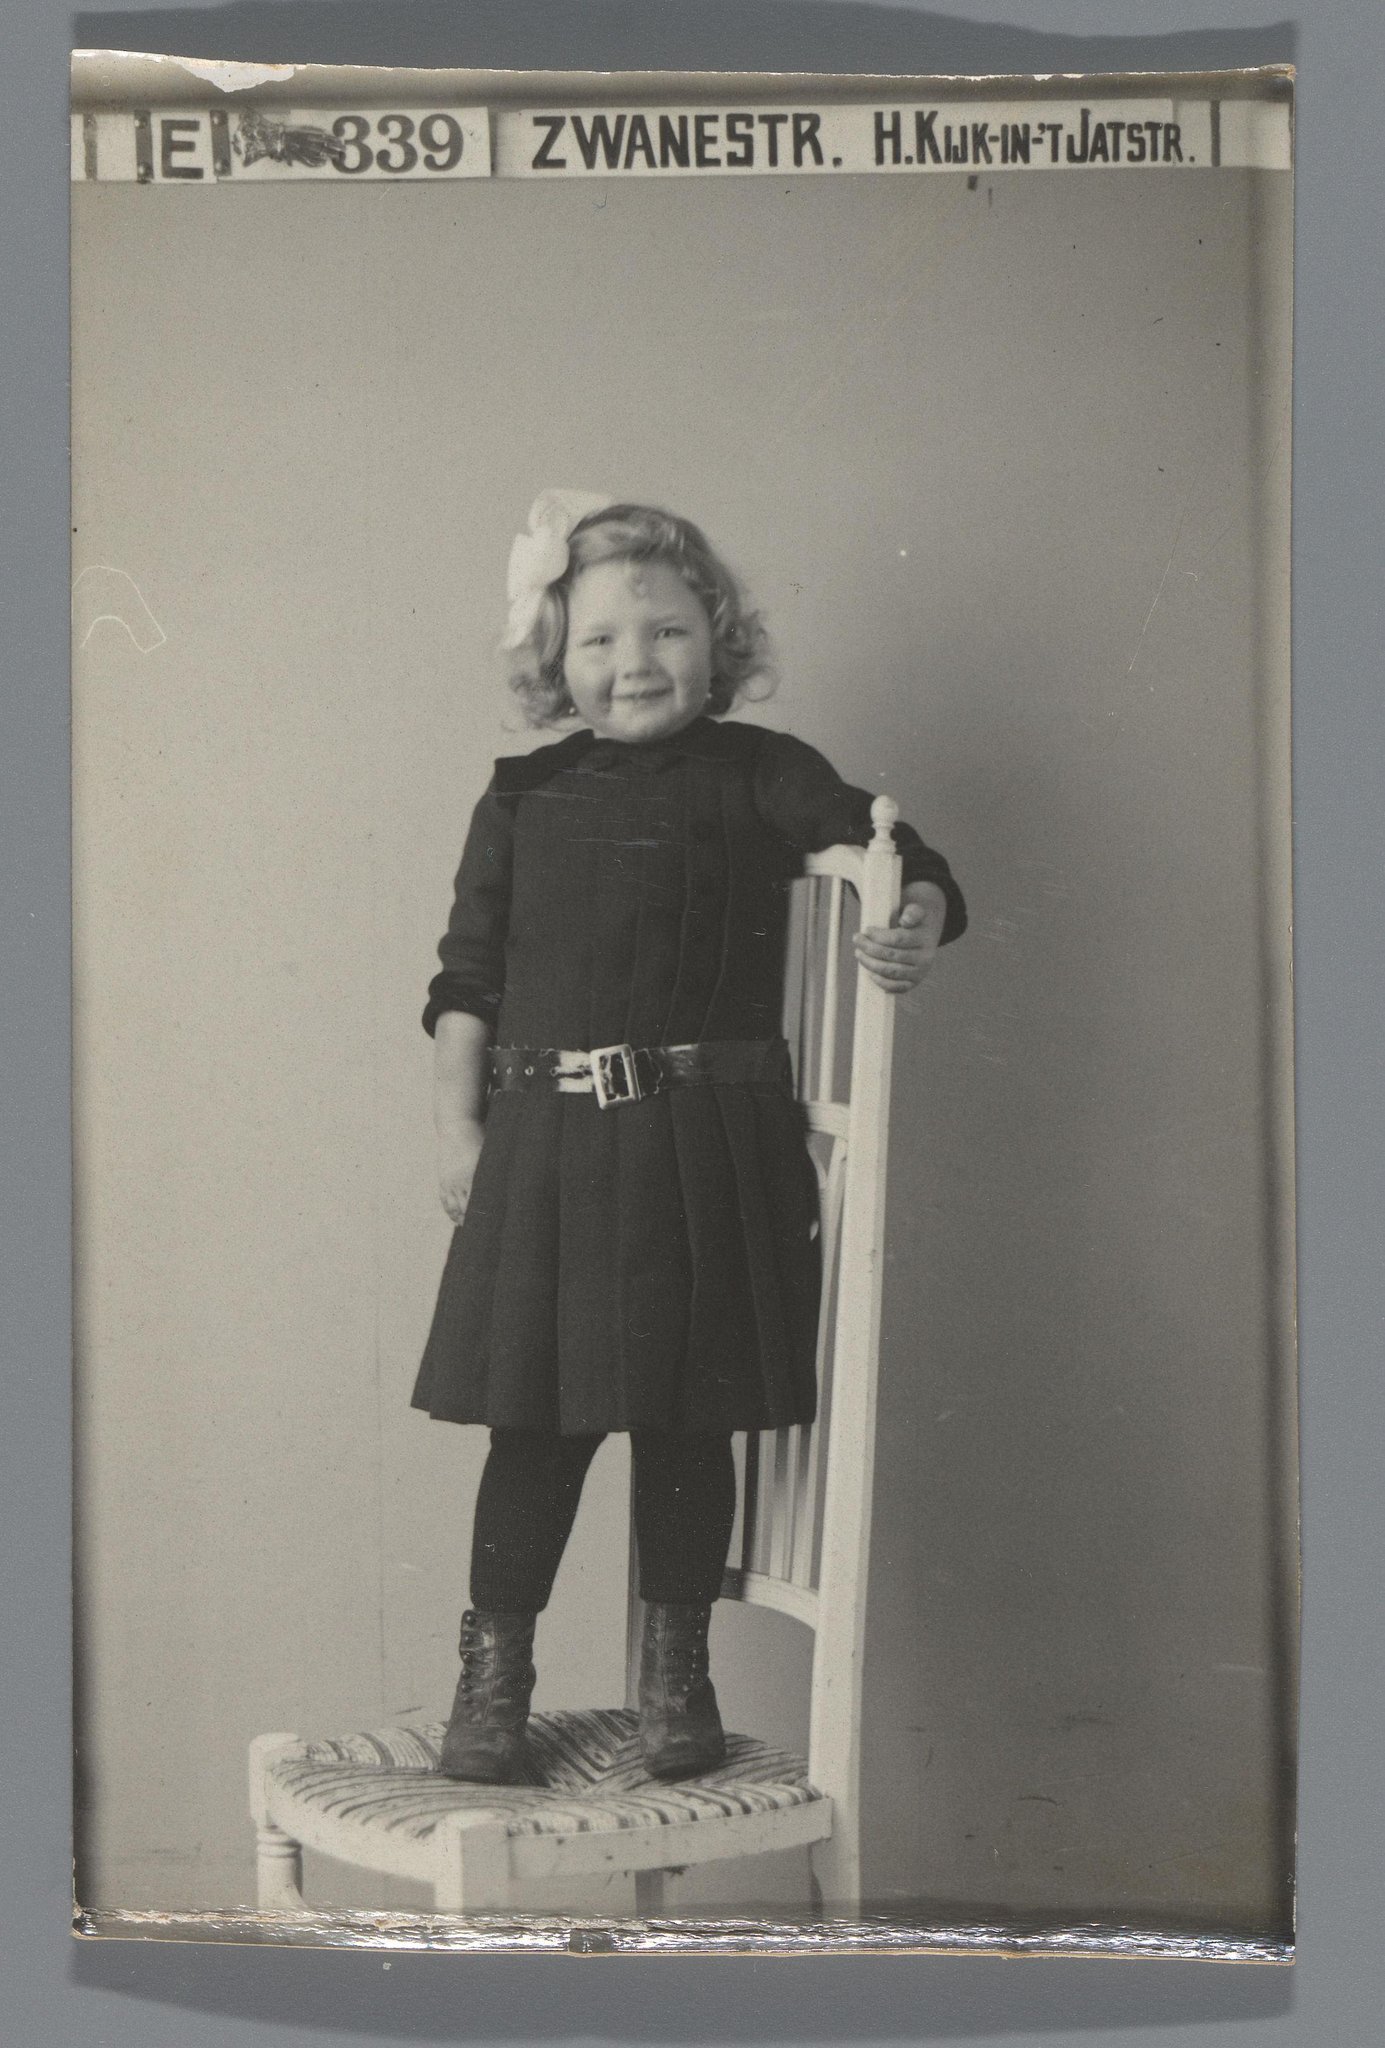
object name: snapshot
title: Portret van een meisje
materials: photographic support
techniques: gelatin silver print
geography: groningen